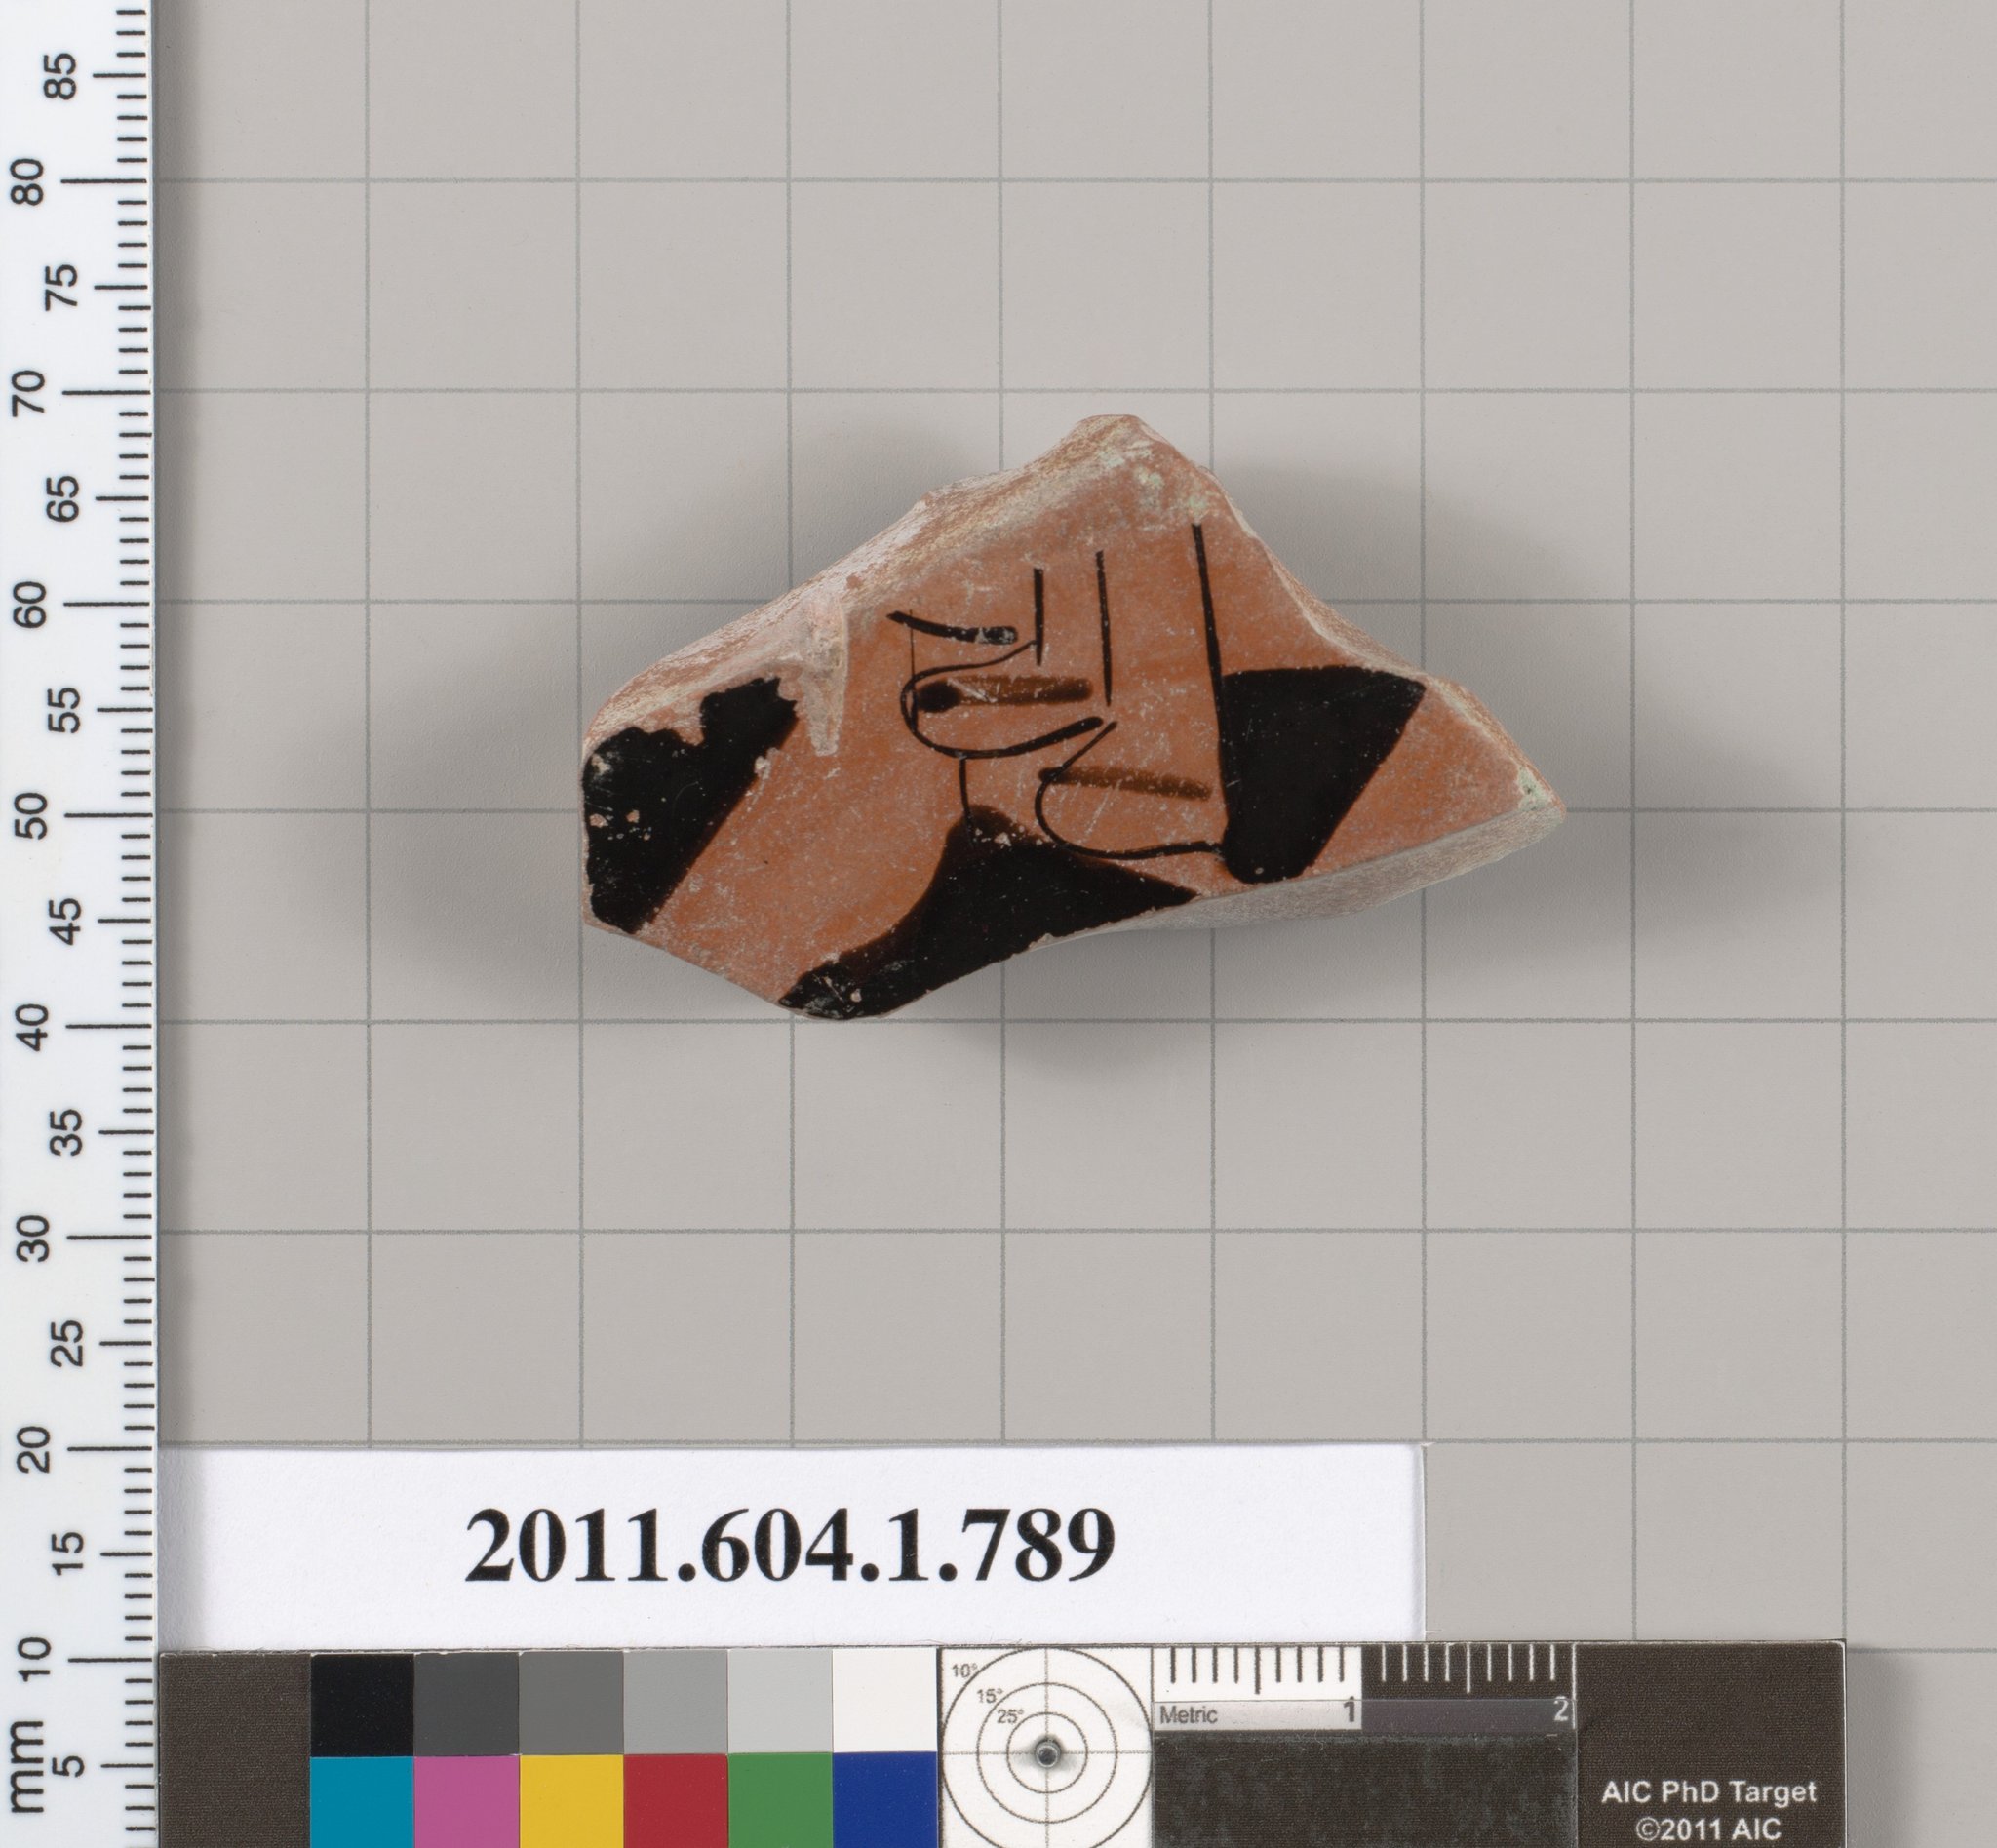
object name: kylix fragment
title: Terracotta fragment of a kylix (drinking cup)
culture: greek, attic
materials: terracotta